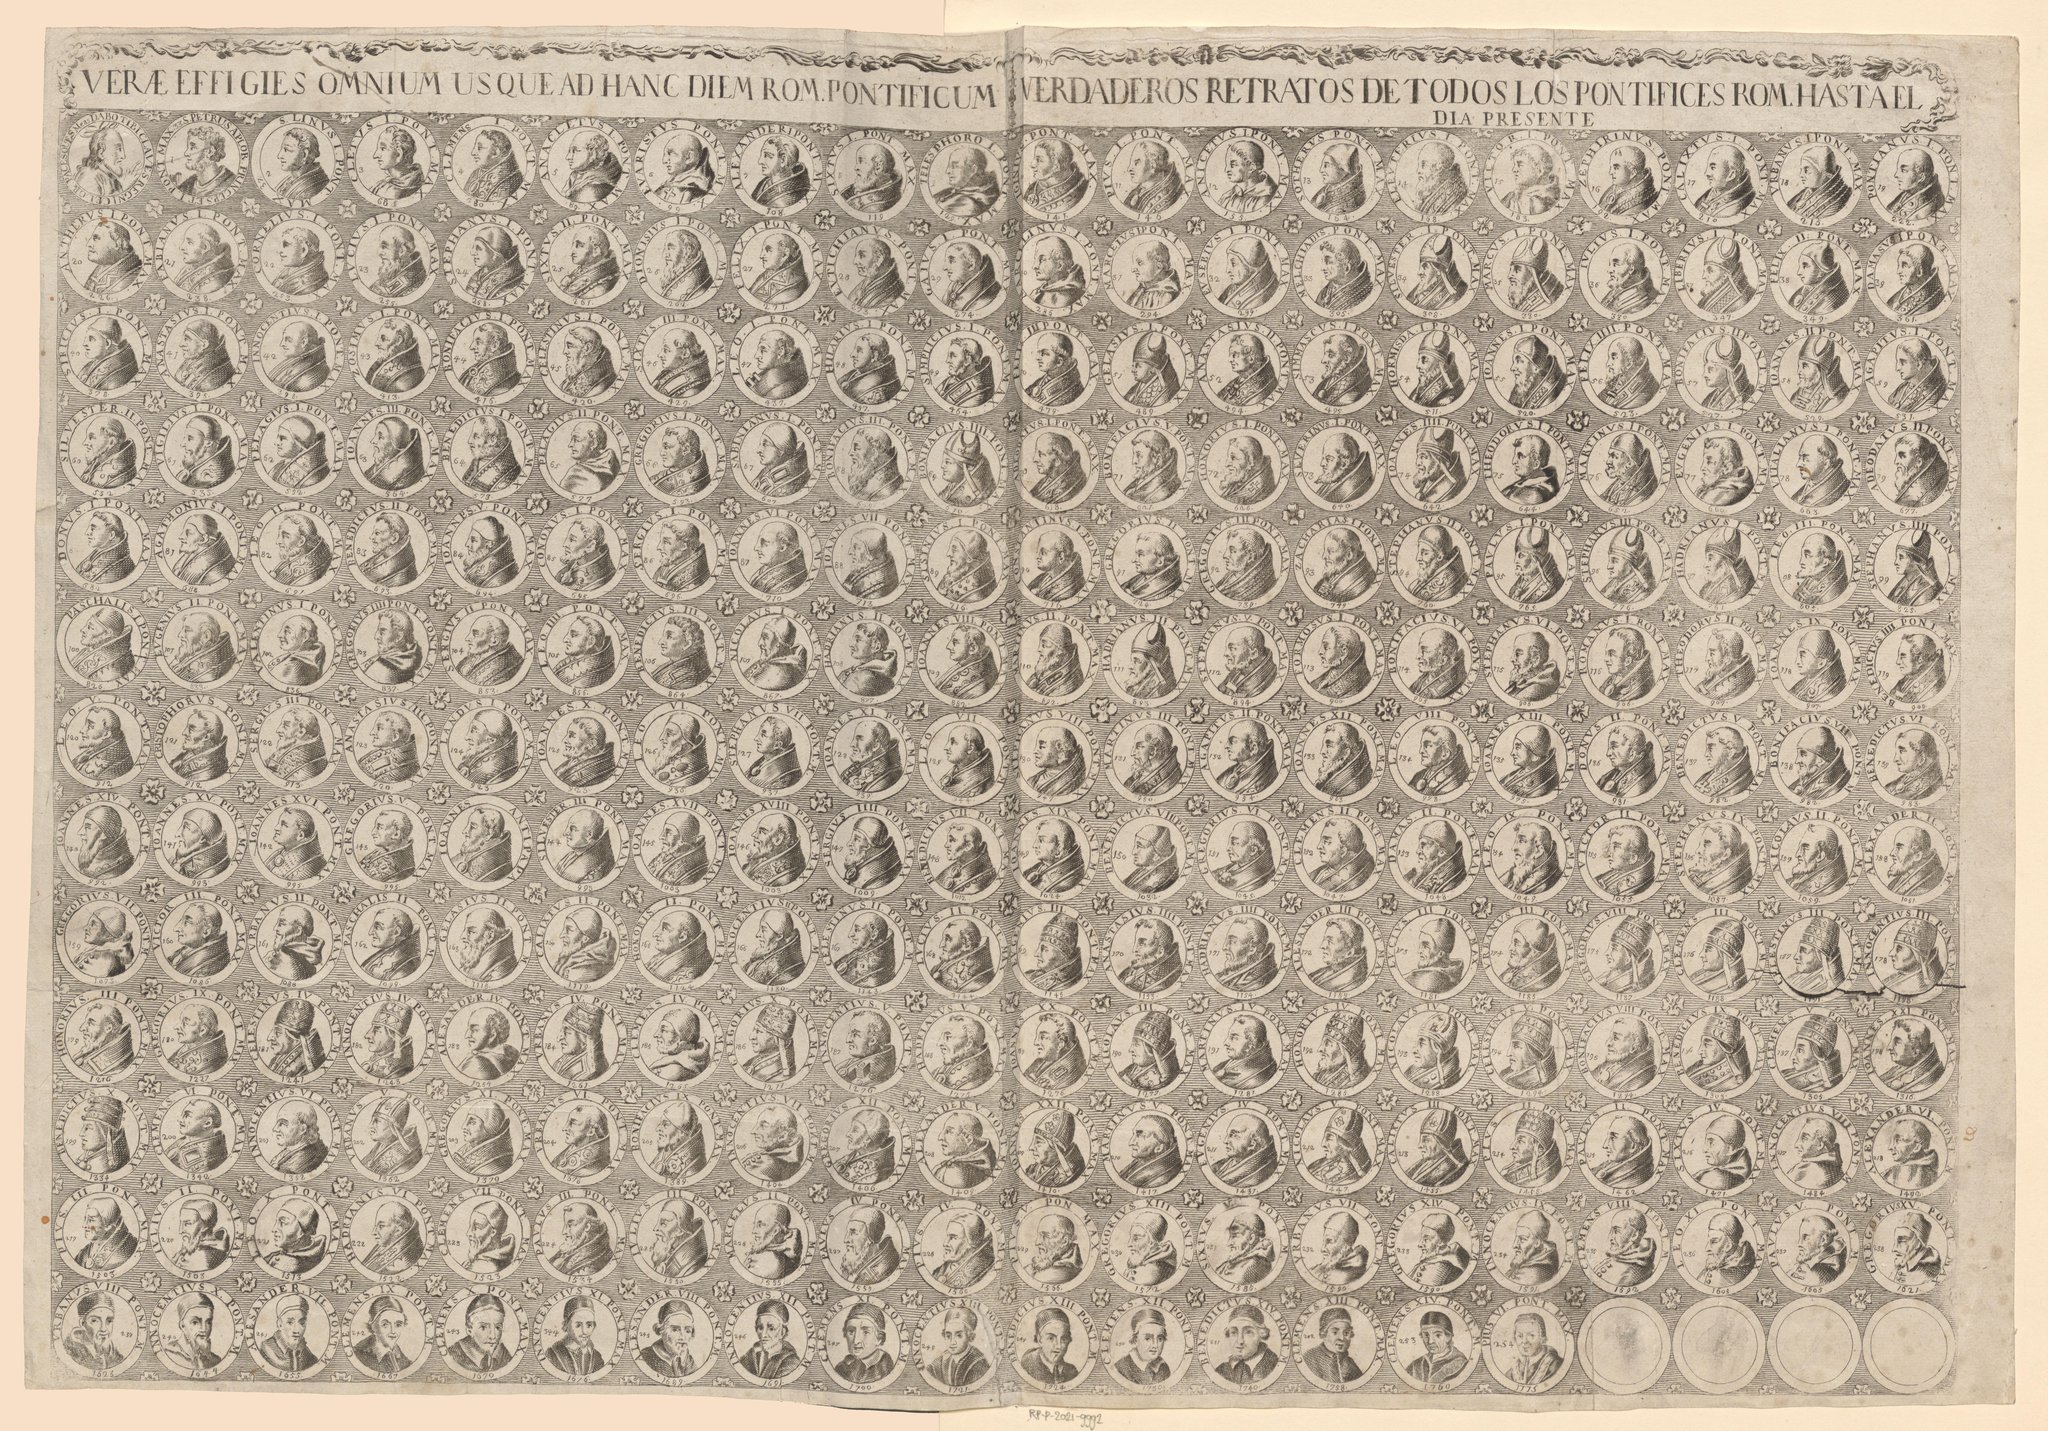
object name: print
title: Portretten van 255 pausen van Christus en Petrus tot Pius VI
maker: Anonymous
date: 1775-1799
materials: paper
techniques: engraving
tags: historical persons, pope